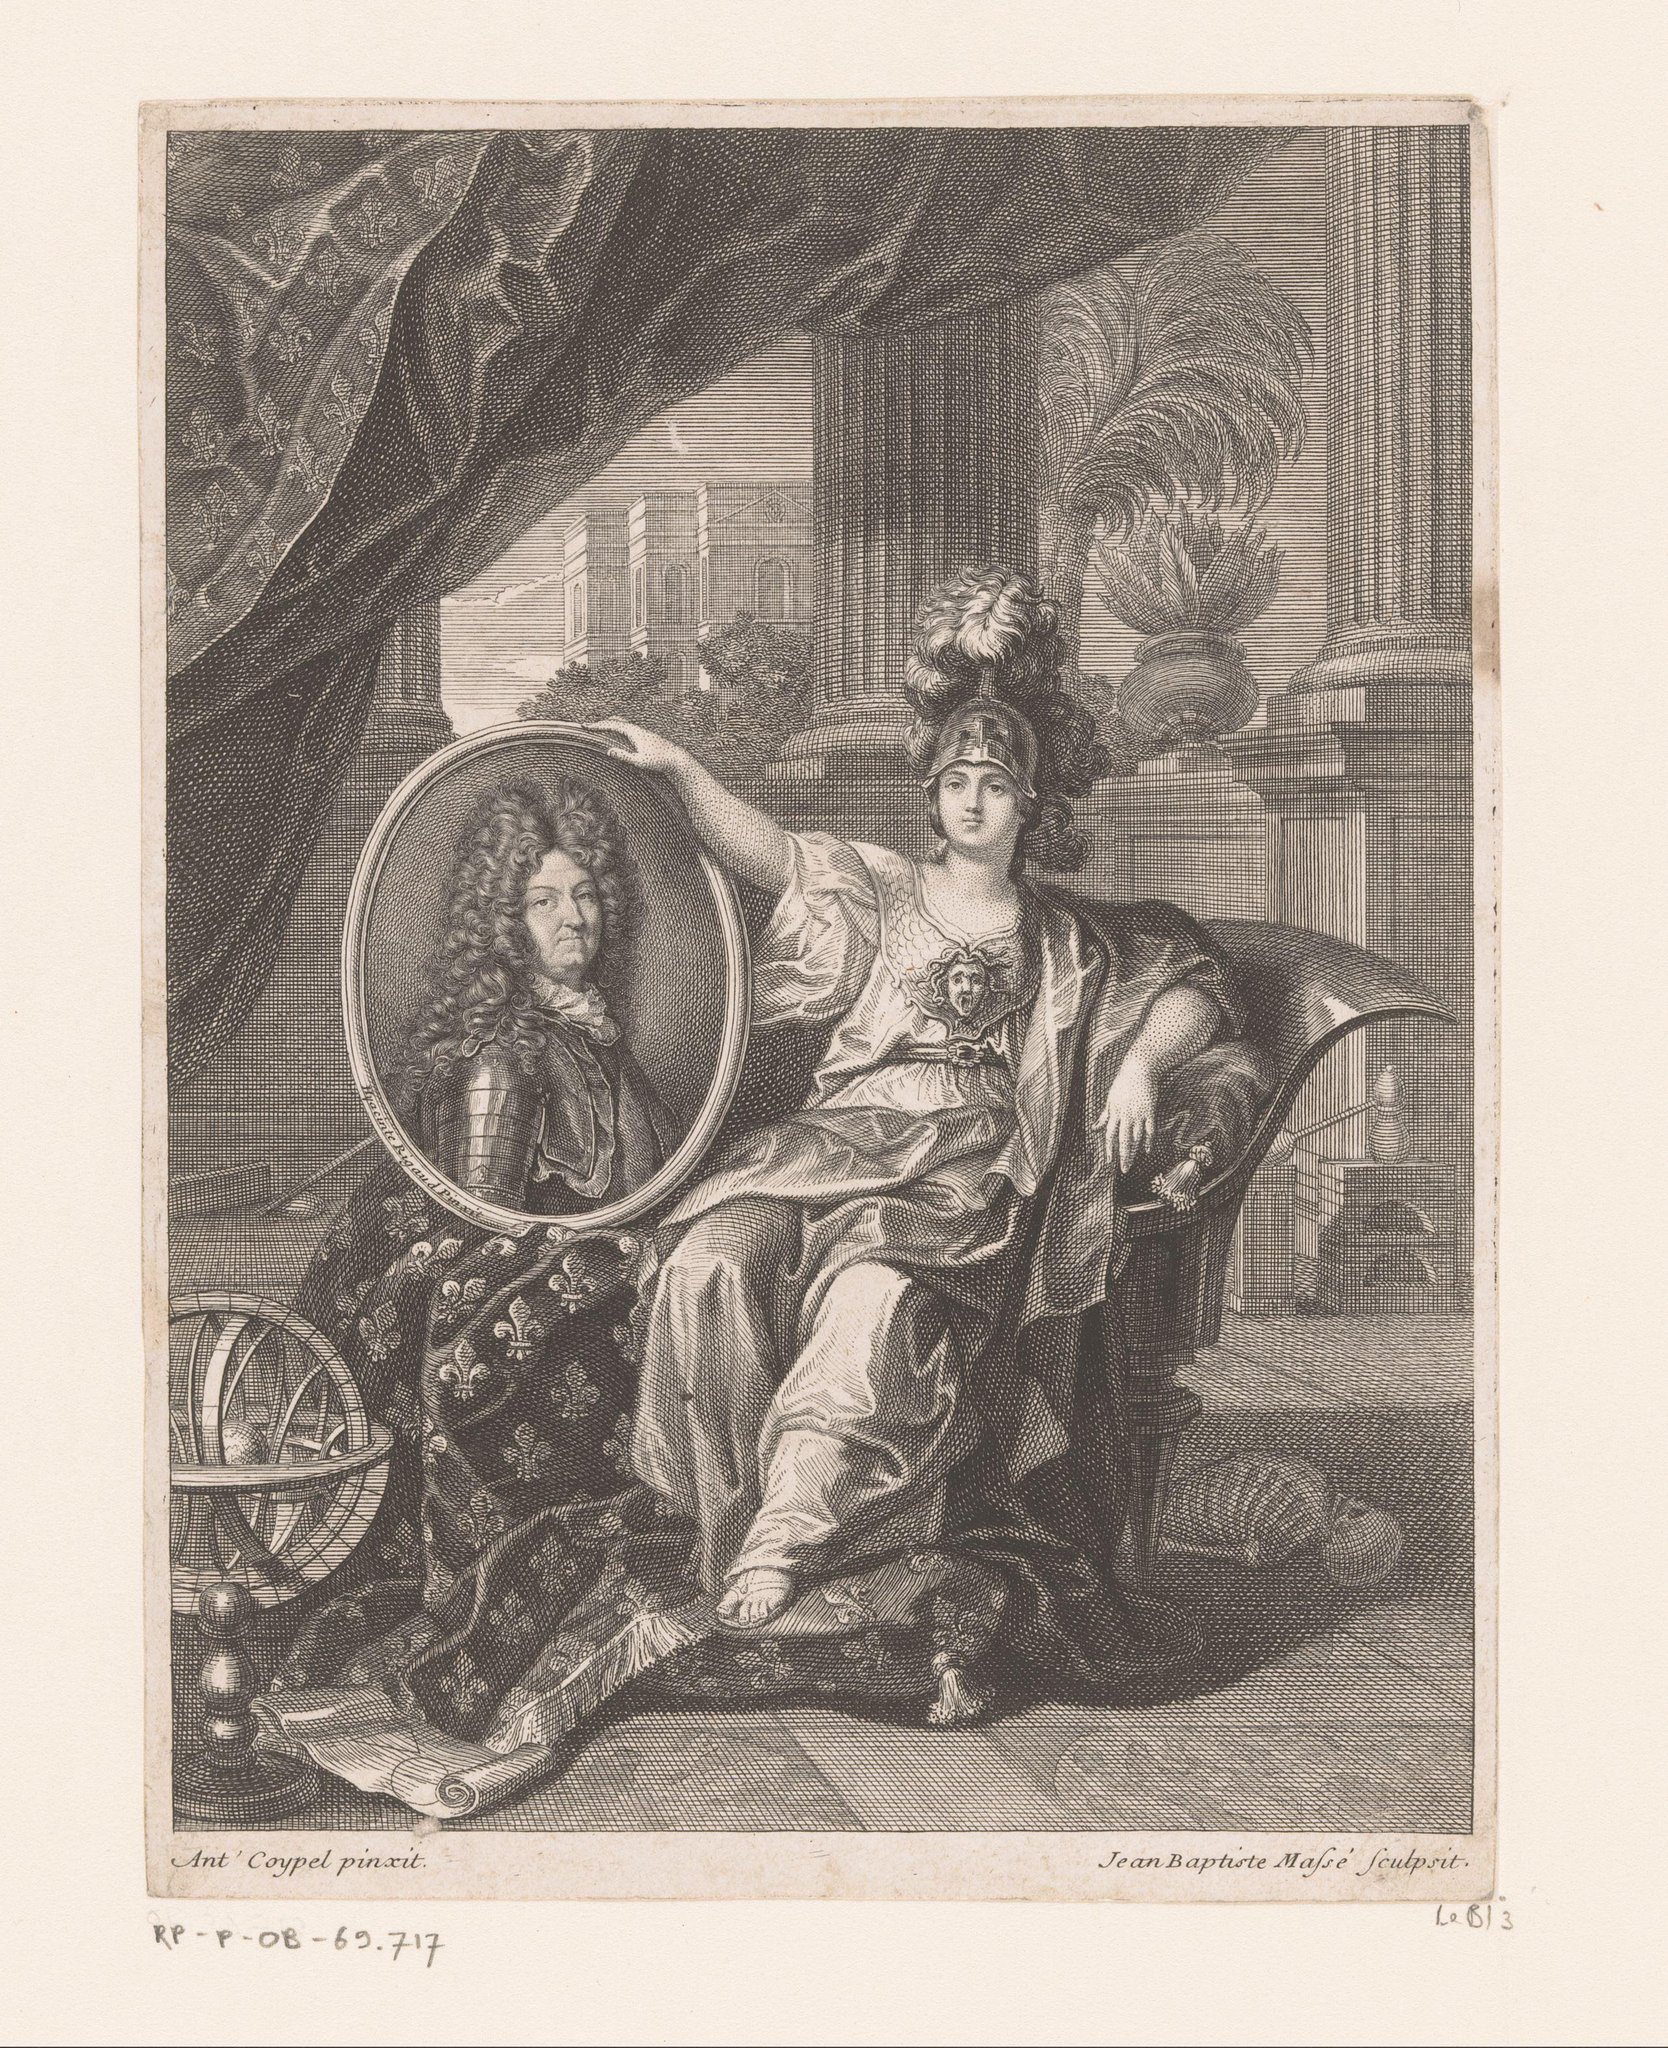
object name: print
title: Portret van Lodewijk XIV in een medaillon opgehouden door Minerva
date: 1697-1767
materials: paper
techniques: engraving, etching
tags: lodewijk xiv (koning van frankrijk), (story of) minerva (pallas, athena), historical persons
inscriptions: number: ‘92’